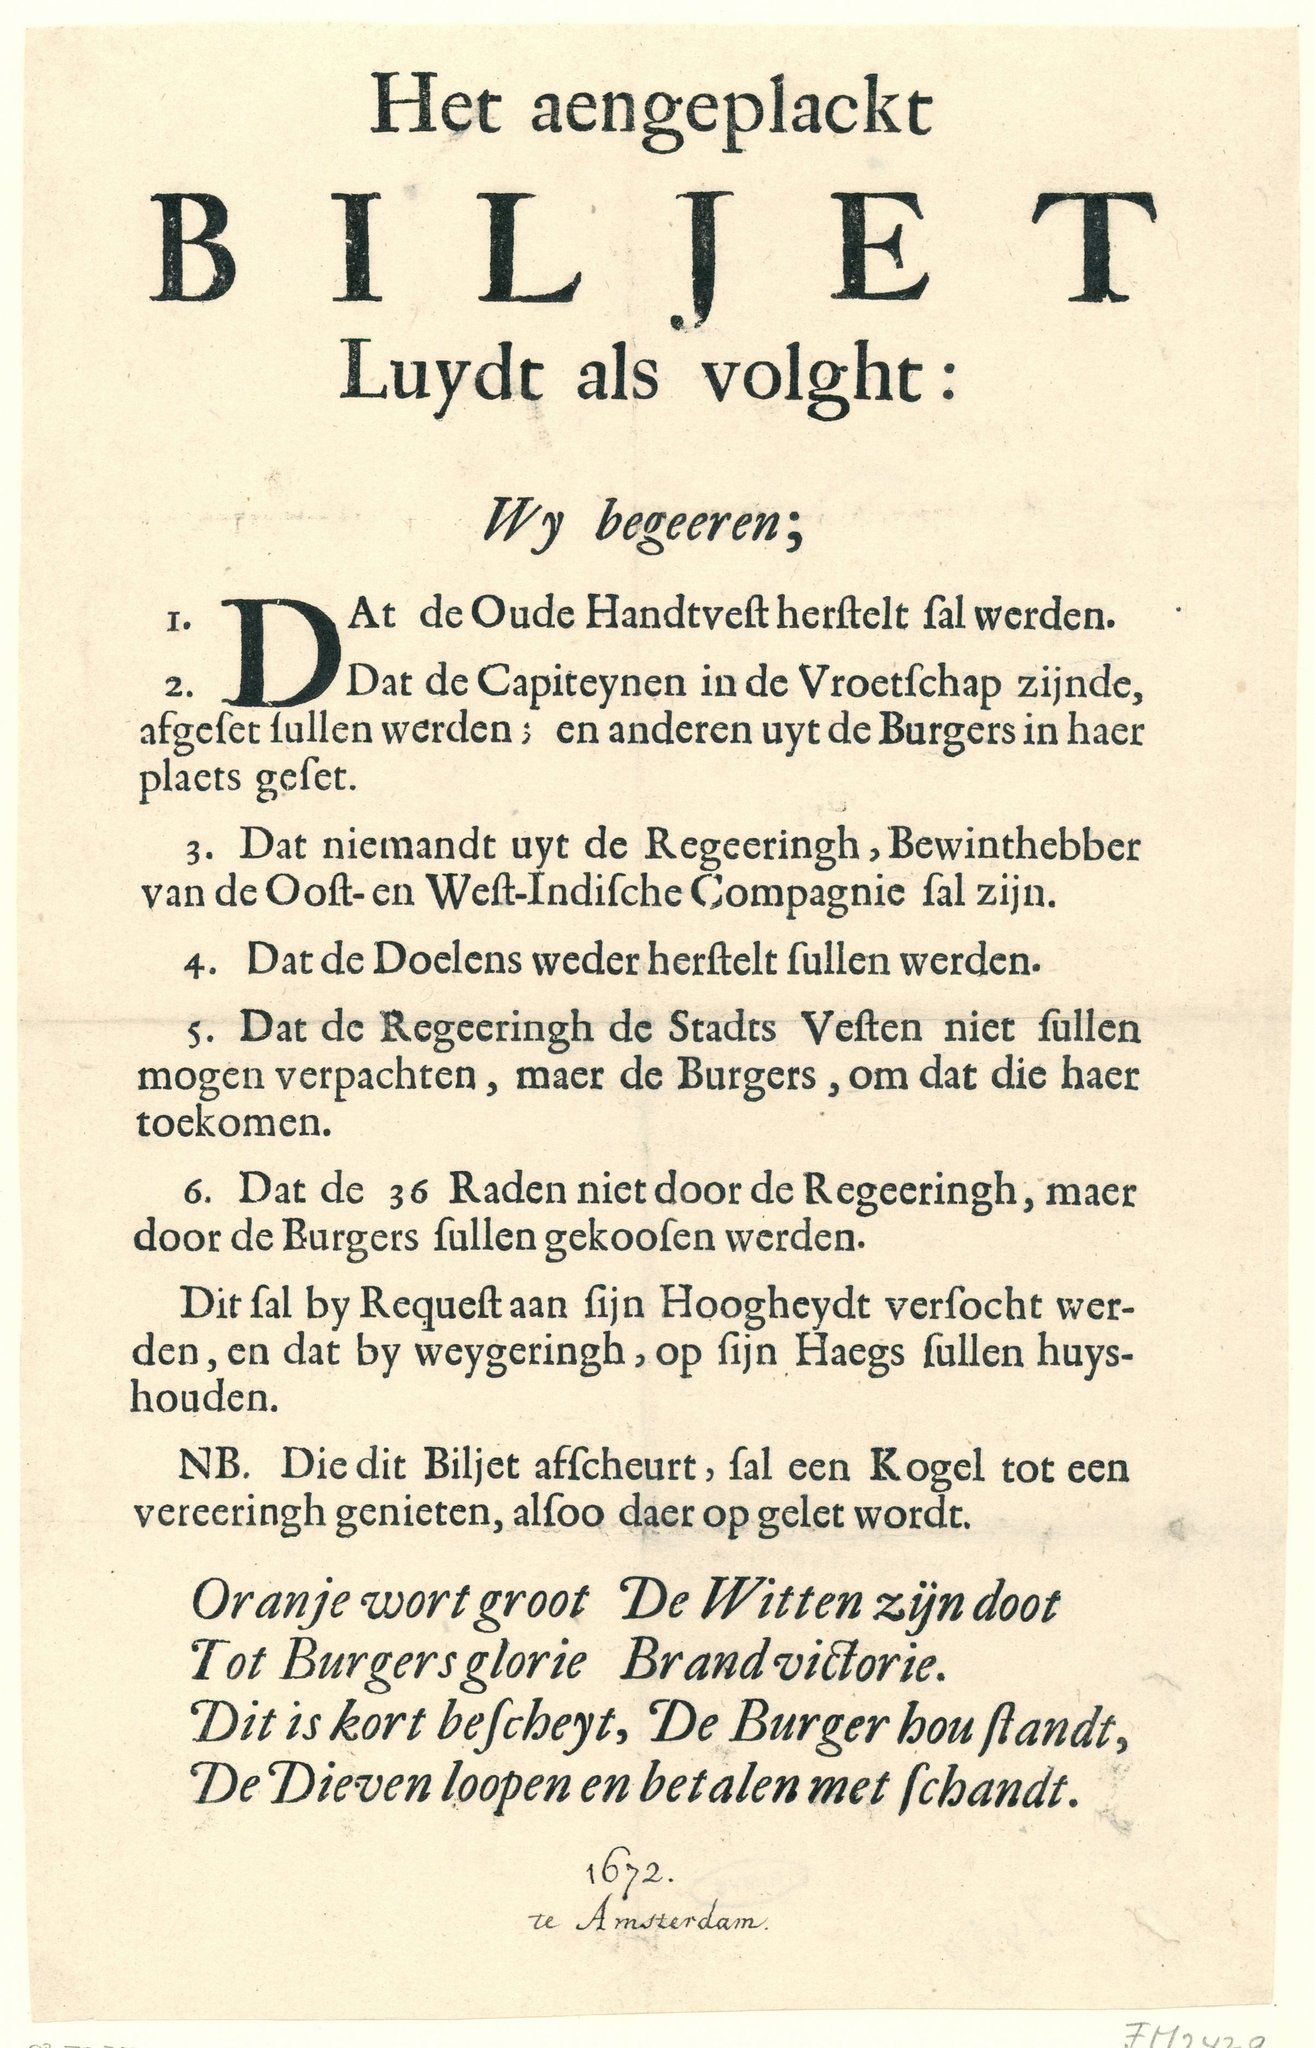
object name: poster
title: Prinsgezind aanplakbiljet, 1672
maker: Anonymous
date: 1672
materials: paper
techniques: letterpress printing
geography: northern netherlands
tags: cornelis de witt, politician, johan de witt, the hague, william iii (prince of orange and king of england, scotland, and ireland), amsterdam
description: Oranjegezind aanplakbiljet waarin zes eisen worden geformuleerd met betrekking tot gewenste veranderingen in de regering. Onder de eisen staat een vers waarin de prins van Oranje wordt geëerd en de dood van de gebroeders De Witt wordt gevierd. Onderaan het blad is met de hand geschreven '1672. te Amsterdam'. Muller vermeldt dat het blad volgens Wagenaar op 23 augustus 1672 in Amsterdam is aangeplakt.